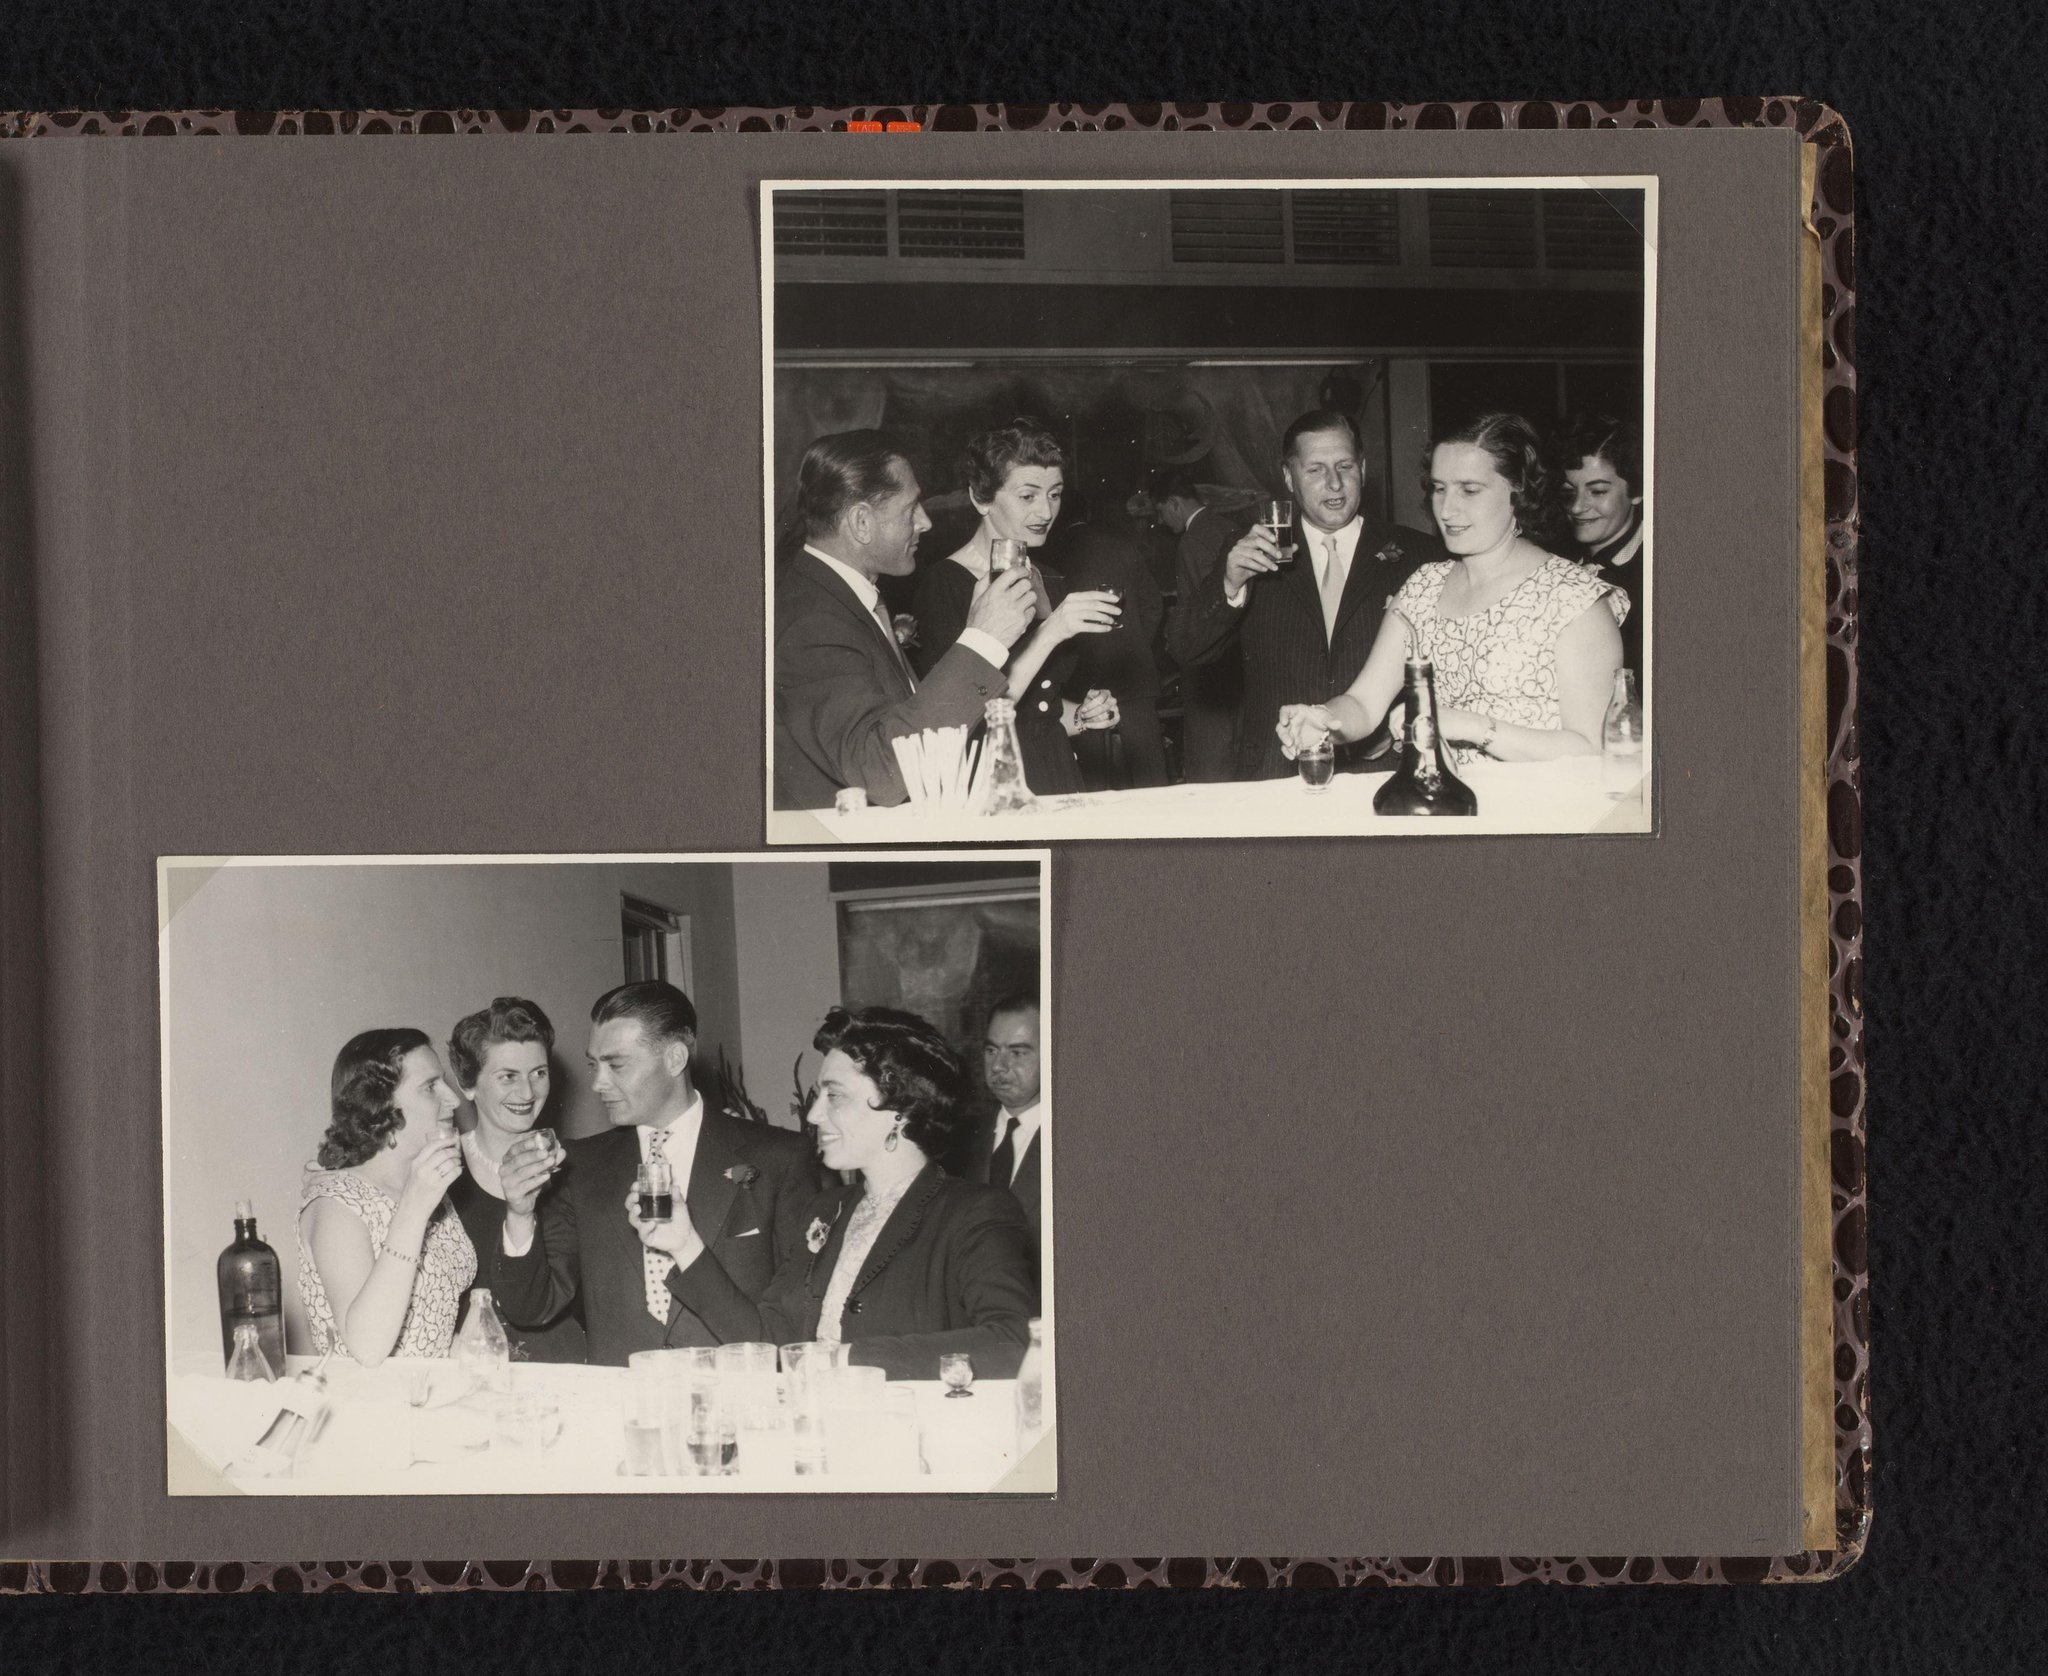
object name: photograph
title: Onbekende collega's van Isabel Wachenheimer tijdens haar periode bij KLM tijdens een feestje en Isabel Wachenheimer, 1947-1955, Israël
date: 1947-1955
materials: cardboard, photographic support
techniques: gelatin silver print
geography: israel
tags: leiden, isabel wachenheimer-elon, historical persons - bb - woman, historical persons not known by name - bb - woman, historical persons not known by name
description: Blad bevat twee foto's van Isabel Wachenheimer (in bewerkte jurk) onbekende collega's. Uit album half formaat, kunstlederen omslag met koordbinding.